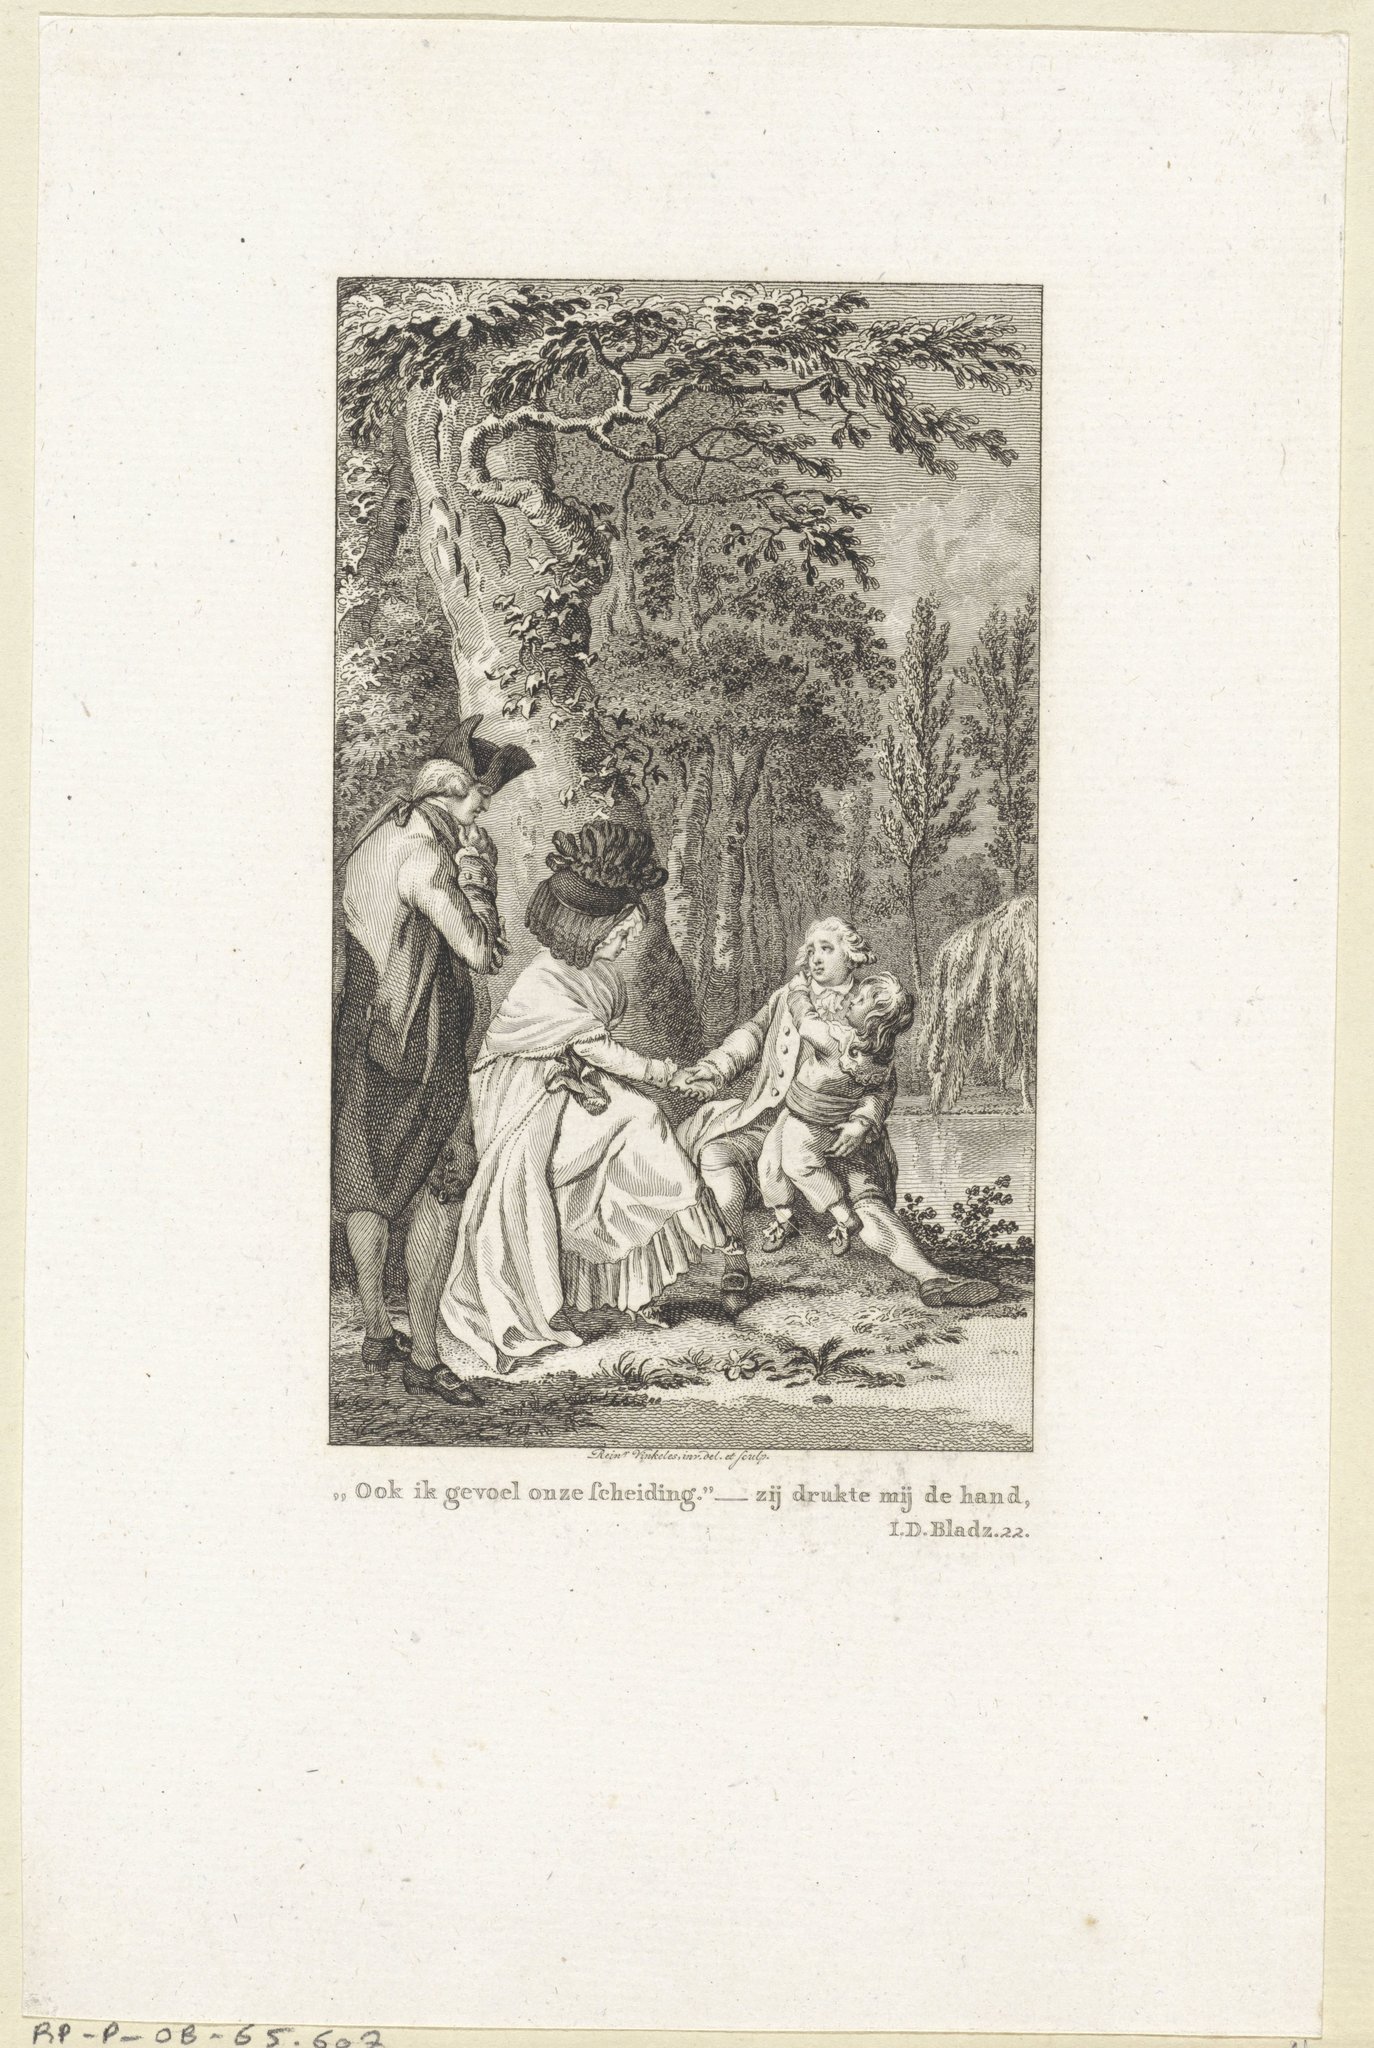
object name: print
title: Bij een bosvijver geven een man en een vrouw elkaar een hand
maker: reinier vinkeles (i)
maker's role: draughtsman, print maker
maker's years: 1741-1816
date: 1751-1816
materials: paper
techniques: engraving, etching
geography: amsterdam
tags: shaking hands, 'dextrarum junctio', forest, wood, pond, pool, father and son(s) (family group)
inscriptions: collector's mark: Lugt 240